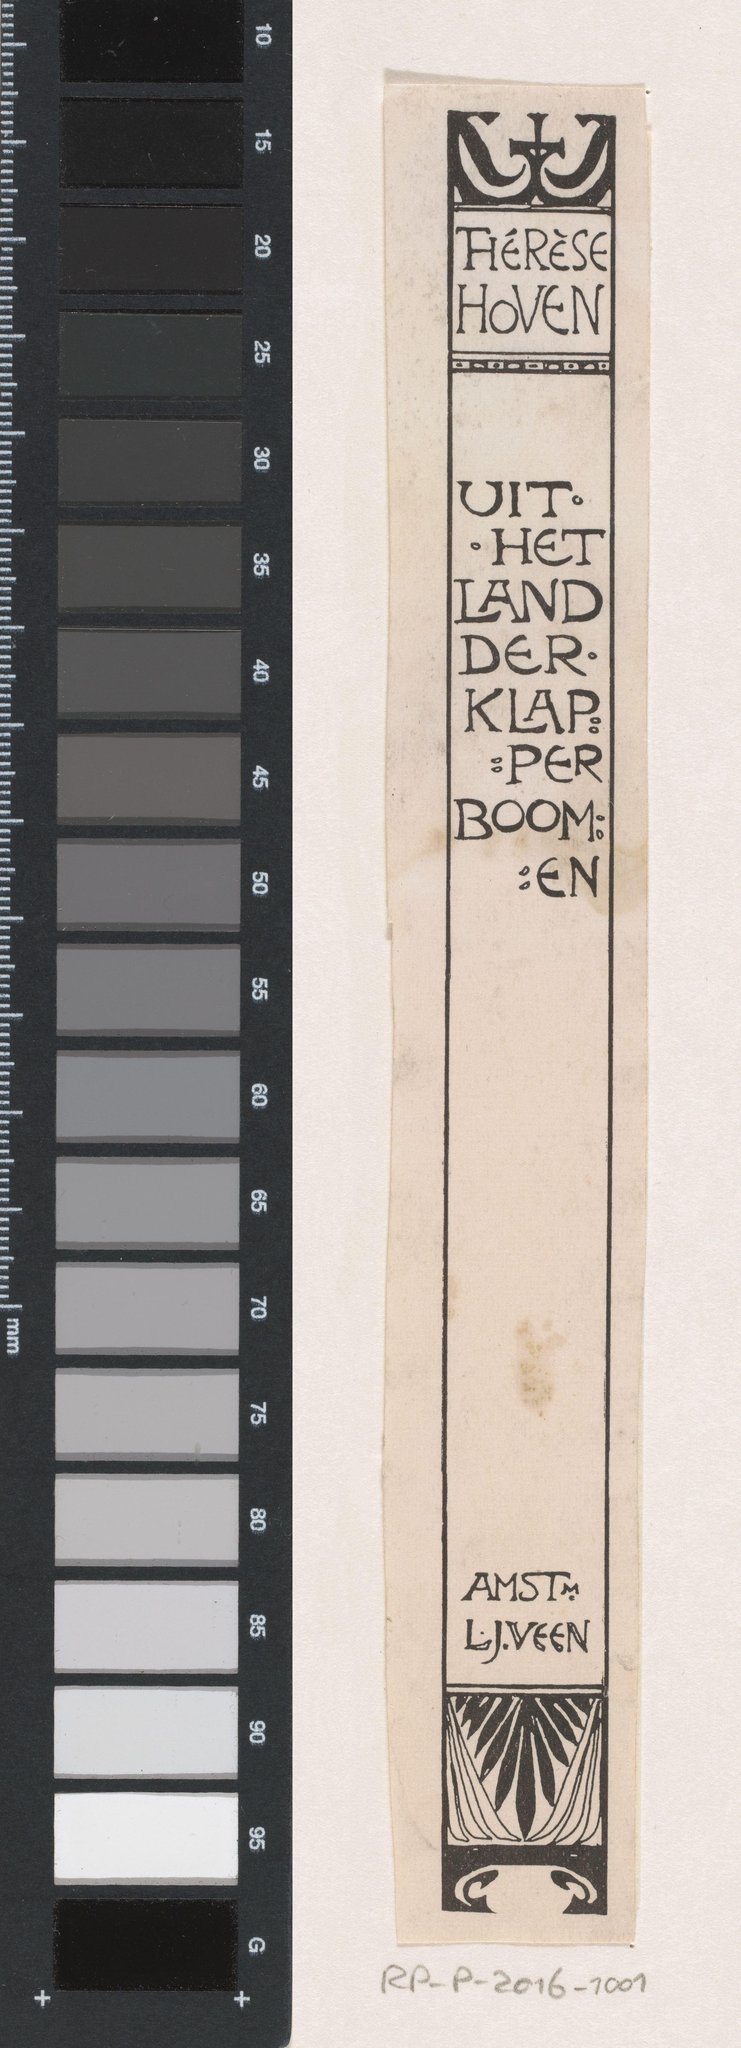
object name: boekrug ontwerp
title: Ontwerp voor een boekrug voor: Thérèse Hoven, Uit het land der klapperboomen, 1897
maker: Anonymous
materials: paper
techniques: printing block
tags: ornaments ~ art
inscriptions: collector's mark: Lugt 2228